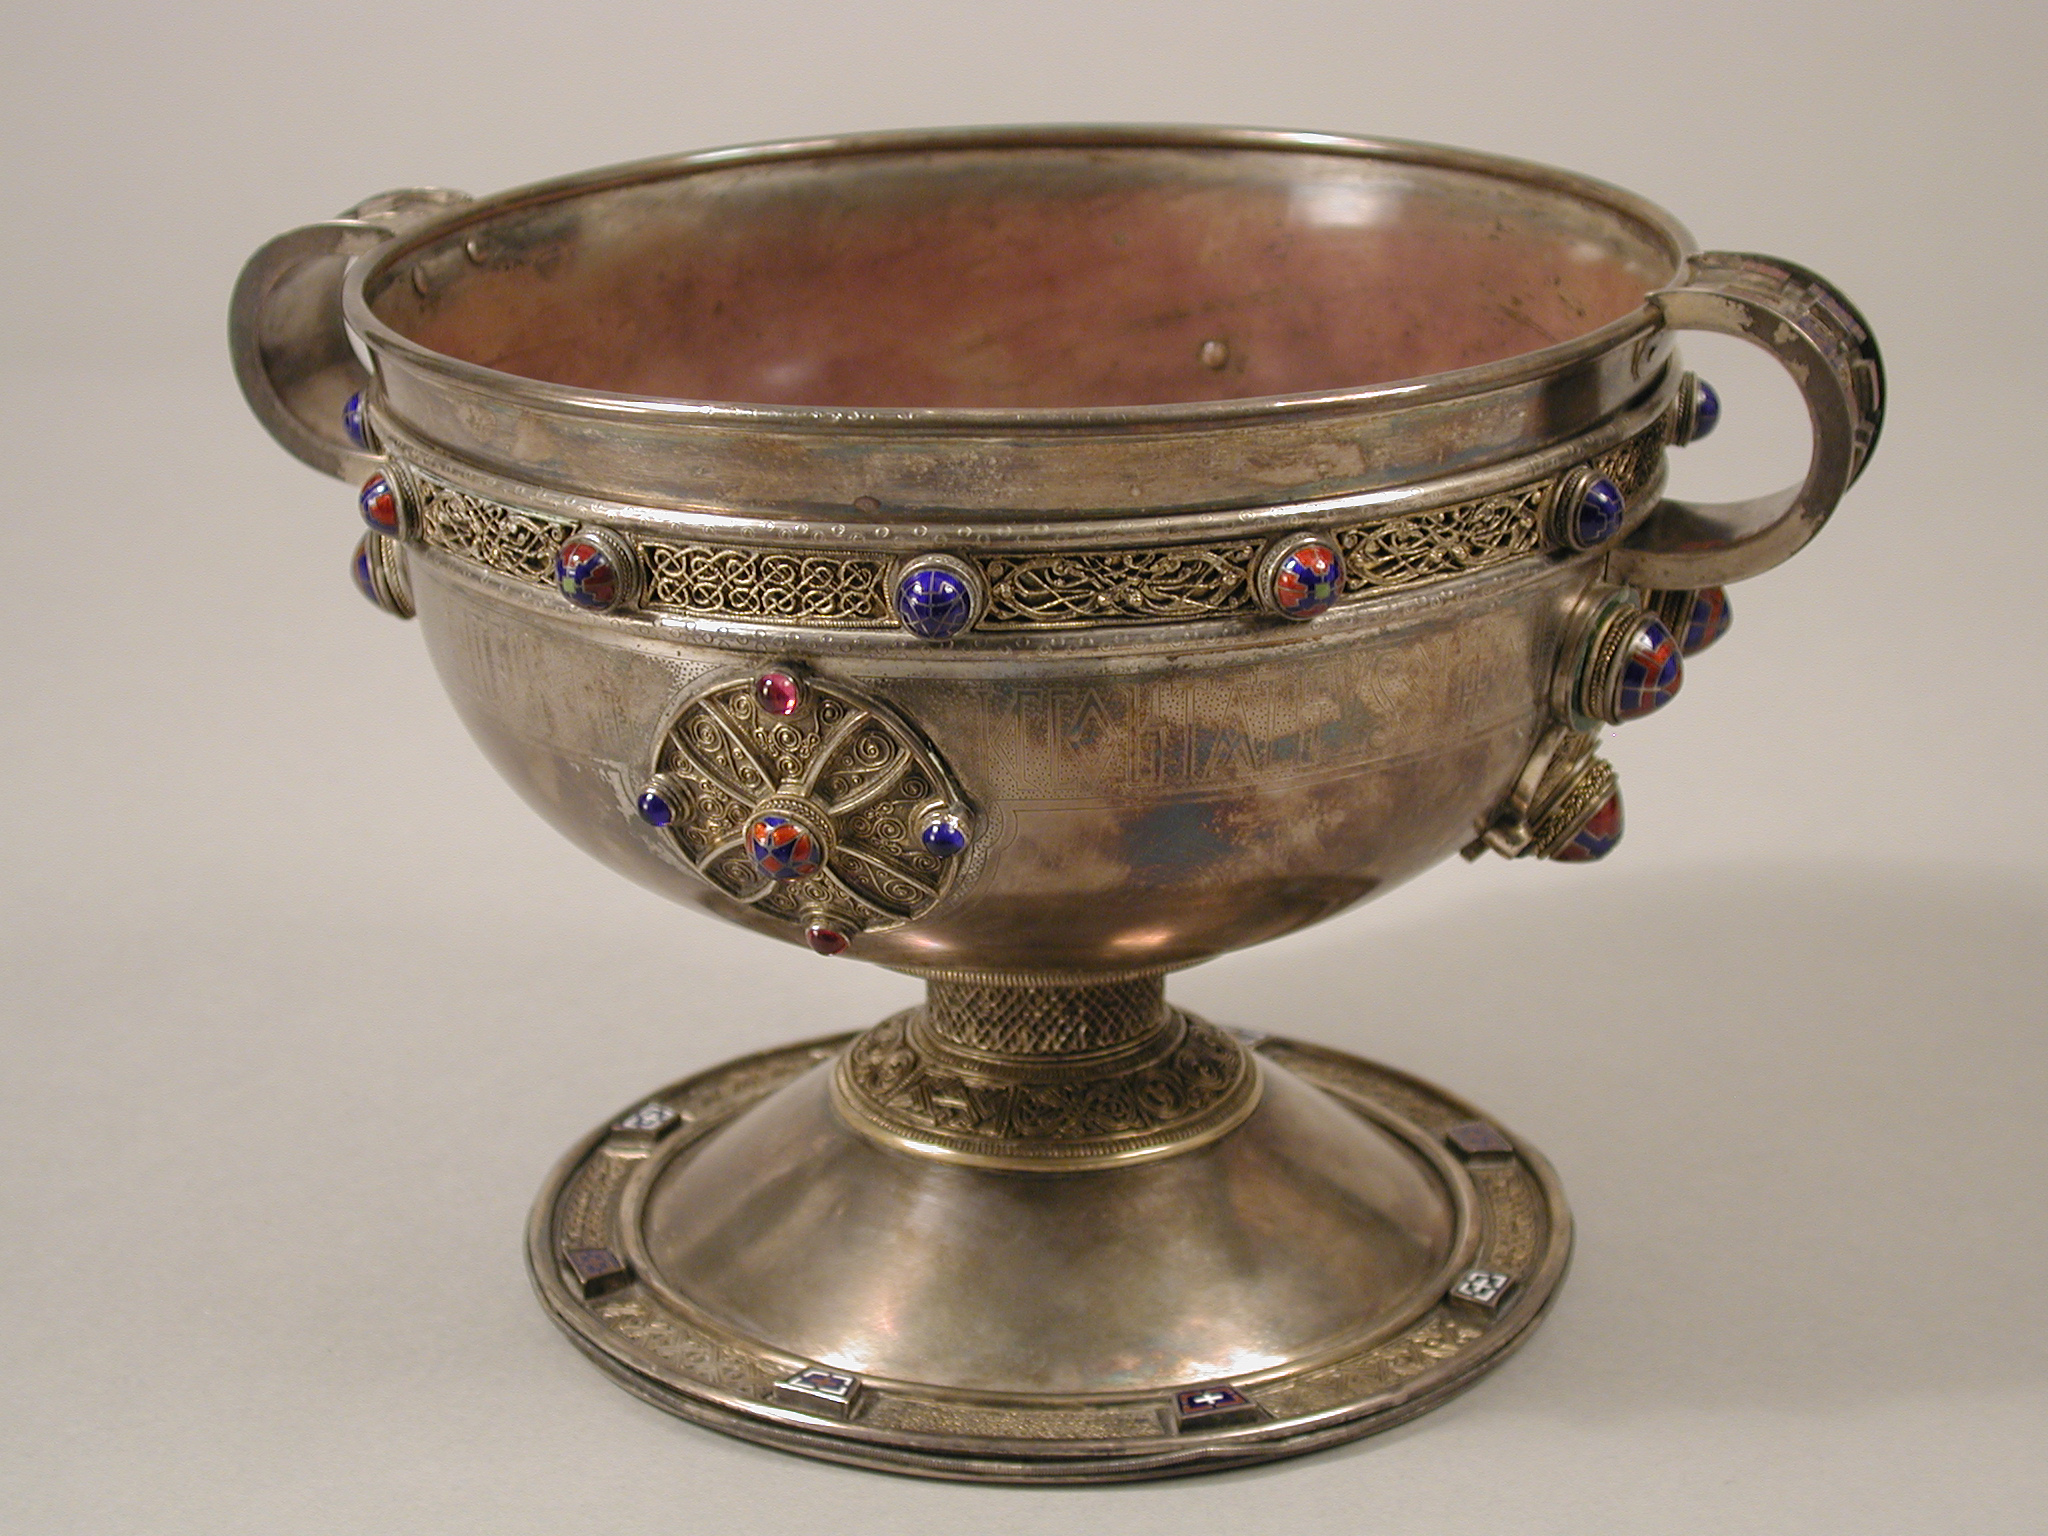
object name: chalice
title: The Ardagh Chalice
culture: irish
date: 1901-1933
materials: alloy, enamel, glass, silver